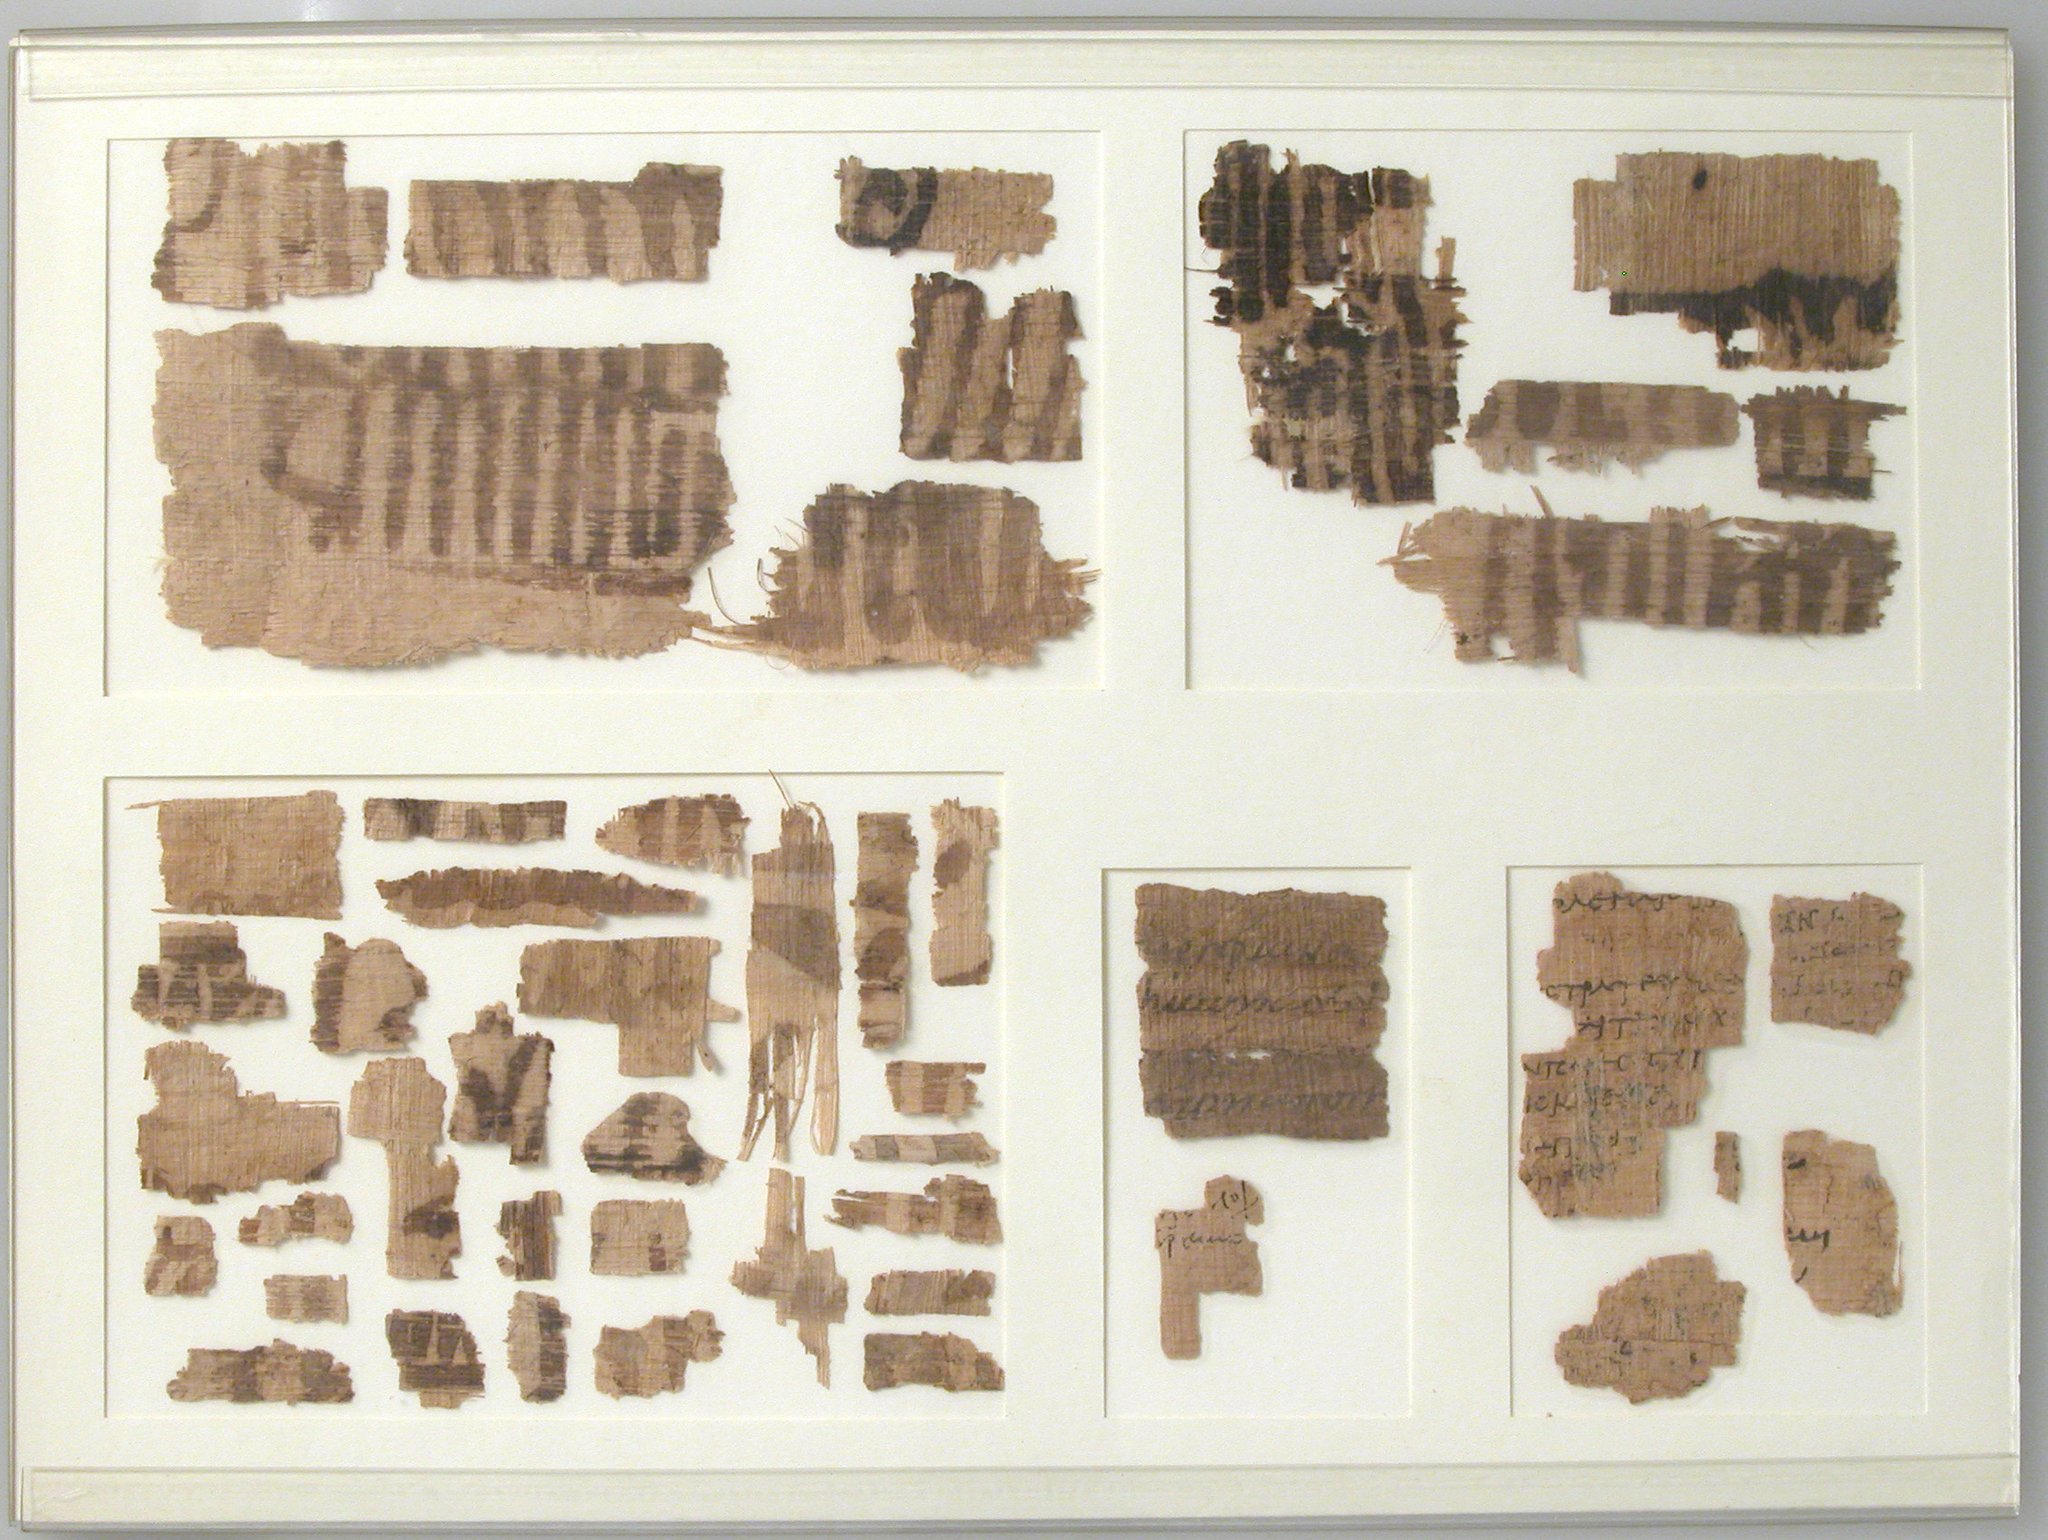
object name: fragment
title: Papyri Fragments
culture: coptic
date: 601-700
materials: ink, papyrus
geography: egypt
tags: documents